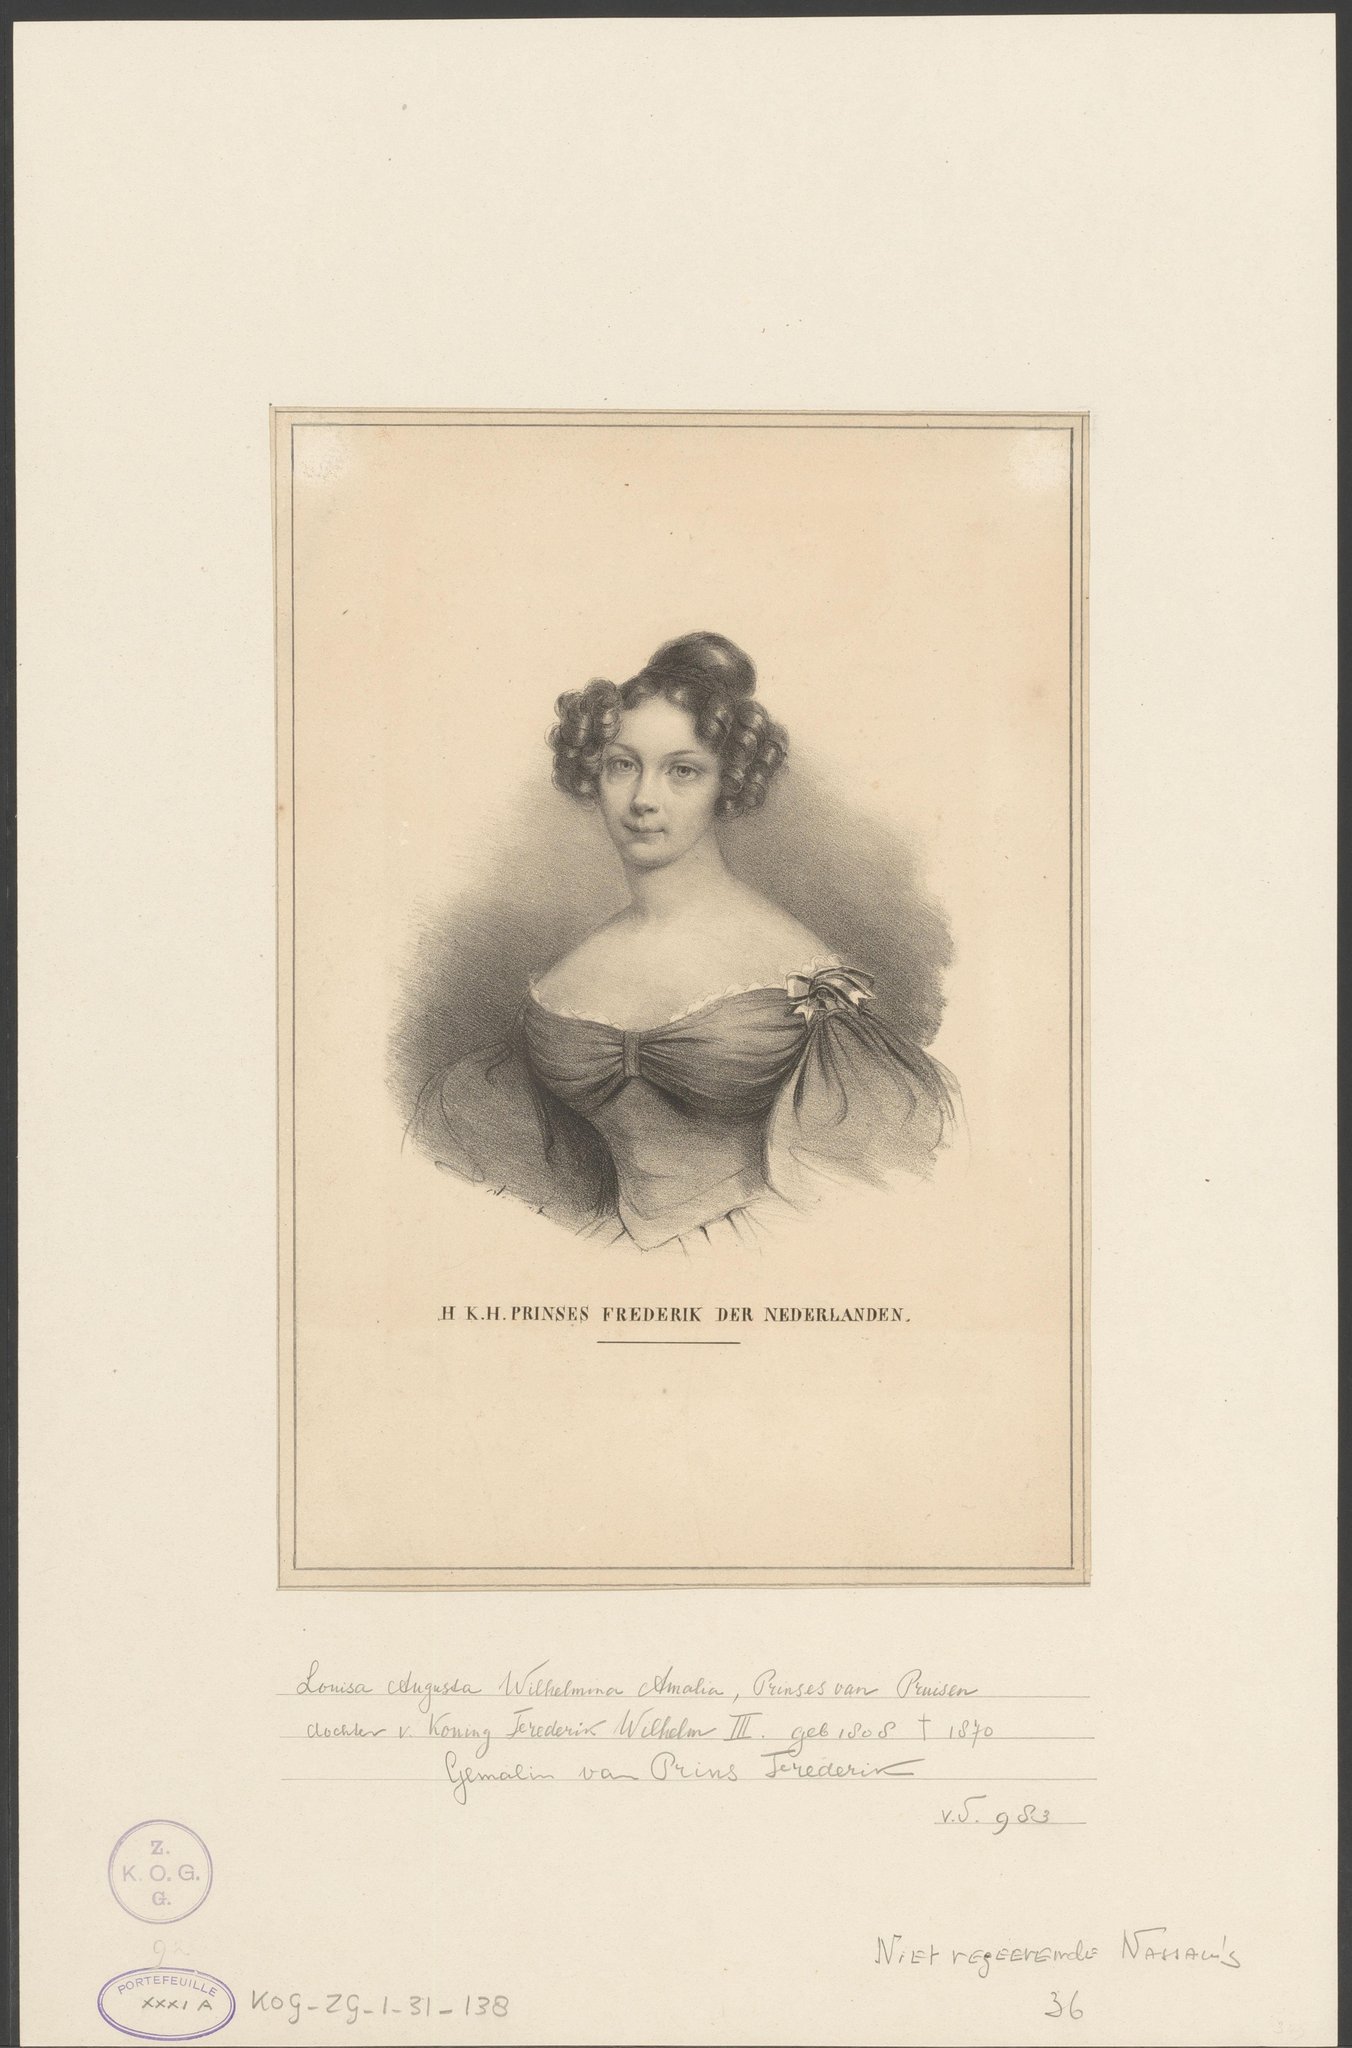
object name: print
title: H.K.H. Prinses Frederik der Nederlanden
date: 1833-1836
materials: paper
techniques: lithograph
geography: amsterdam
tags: berlin, marianne (prinses der nederlanden), historical persons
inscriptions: stamp, collector's mark: Lugt 1641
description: Portret van Marianne, prinses der Nederlanden. Onderwerpsrubrieken binnen de Atlas Zeden en Gewoonten: Portretten, Portretten van Vorsten uit het huis van Oranje, Niet regeerende Vorsten.